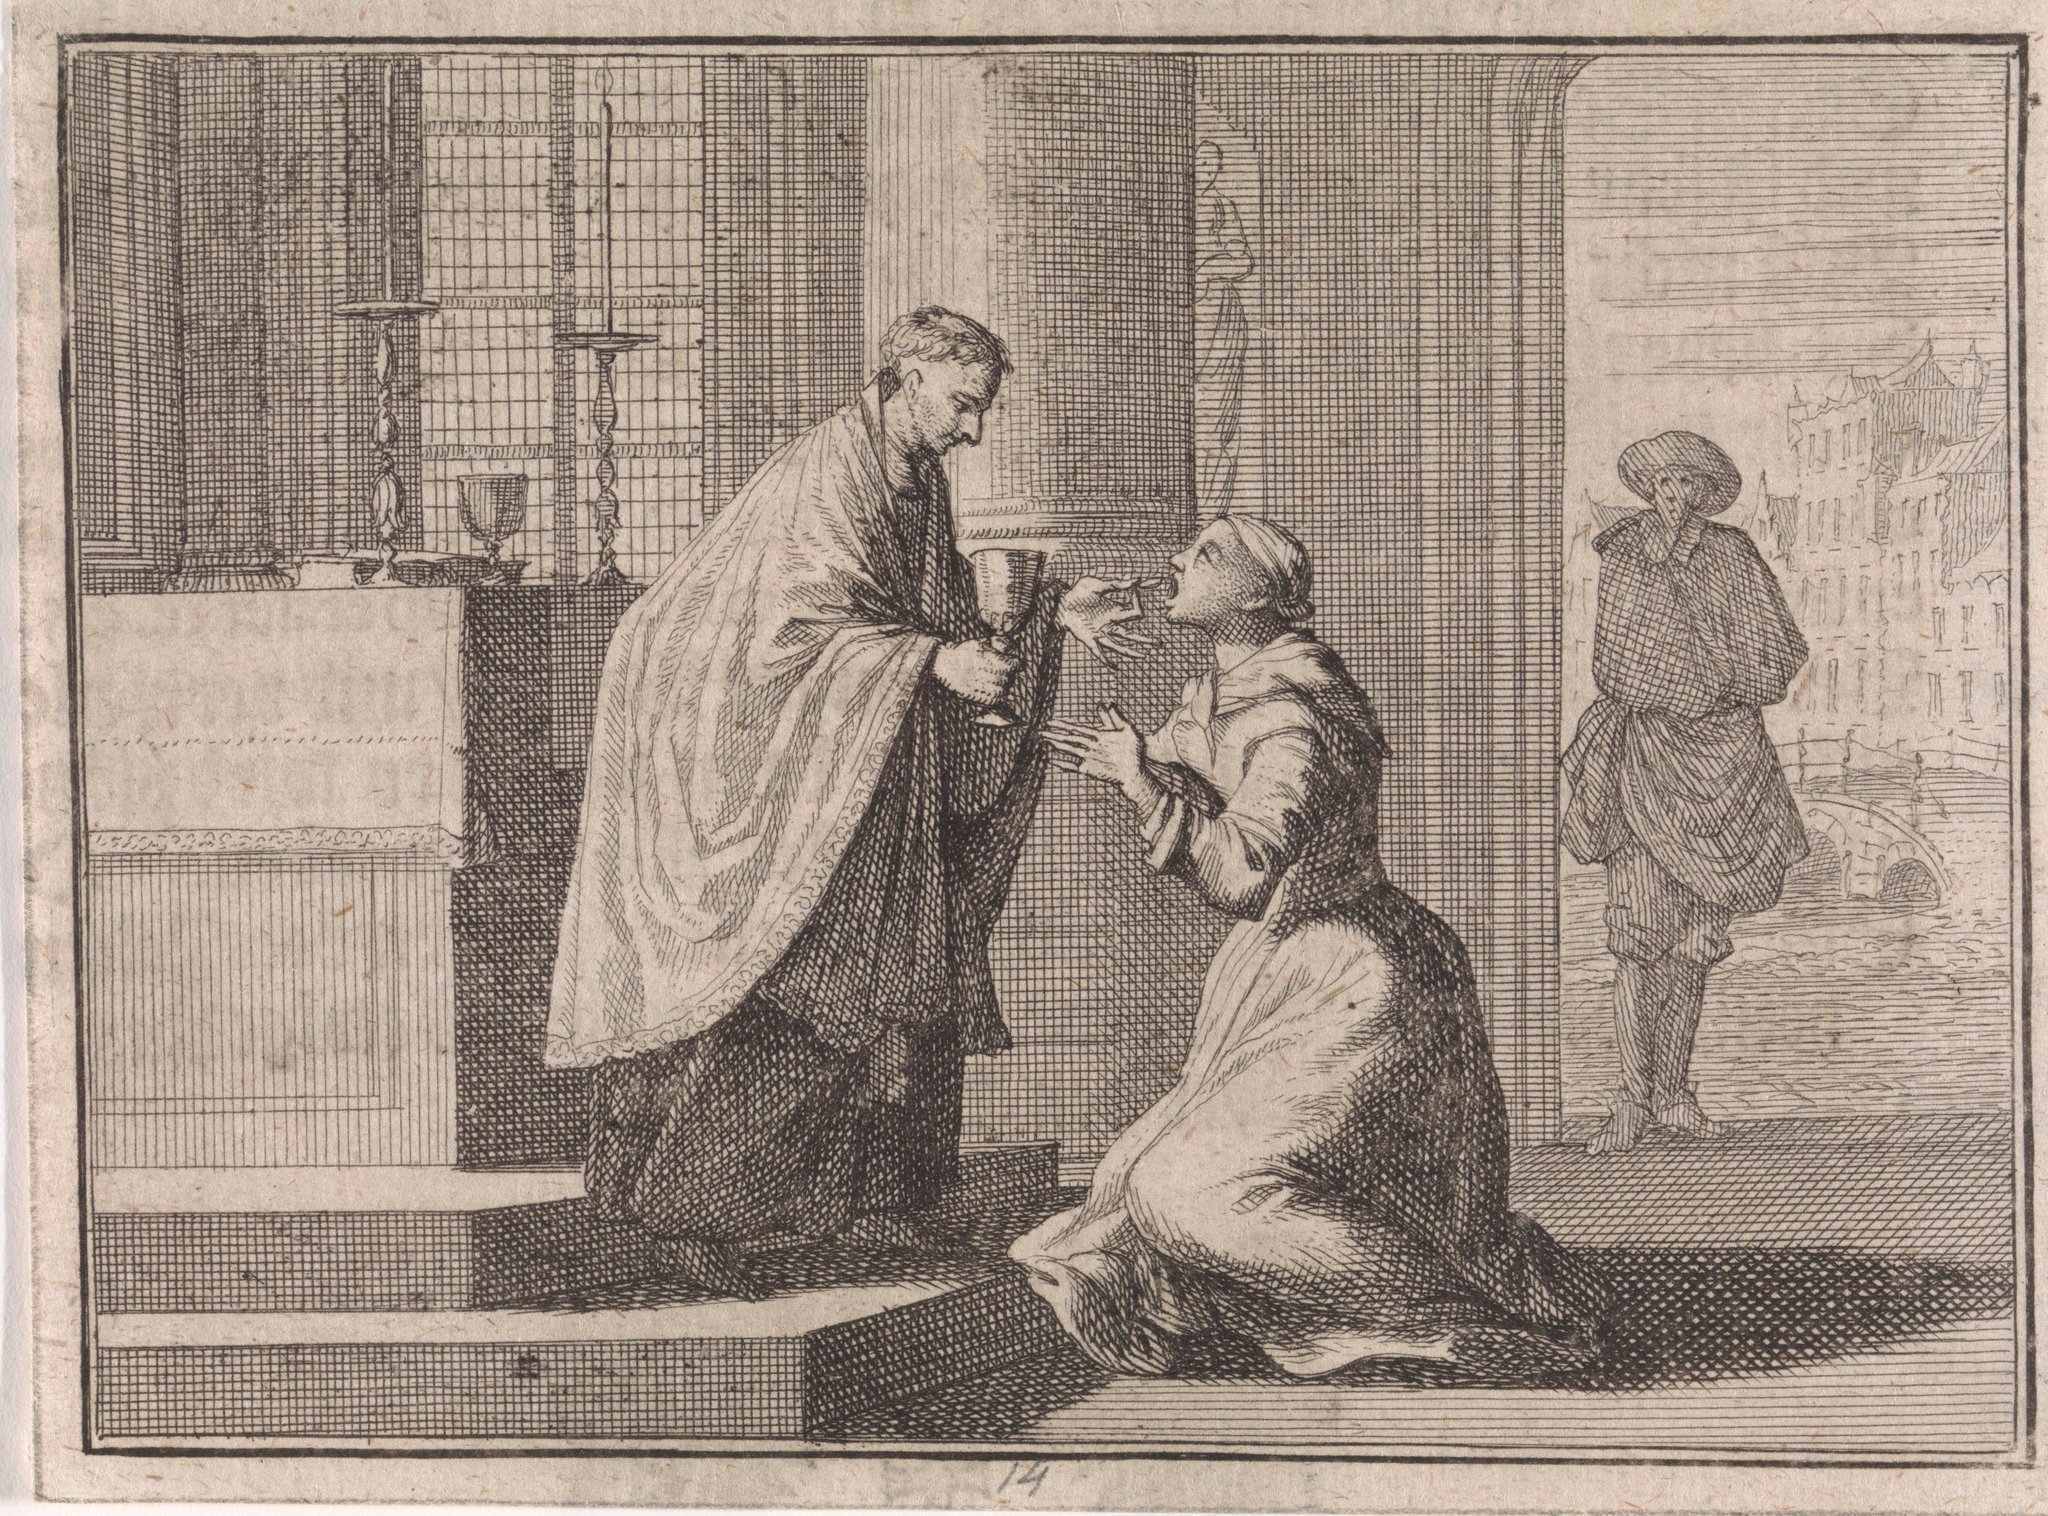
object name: book illustration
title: Wie vermessen in dem Essen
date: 1710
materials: paper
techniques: etching, letterpress printing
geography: nuremberg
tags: bread, host, priest ~ non-christian religions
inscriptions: collector's mark: Lugt 2228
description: Illustratie uit: Abraham a Sancta Clara. Heilsames Gemisch Gemasch, das ist: Allerley seltsame und verwunderliche Geschichten (...). Neurenberg: Christoph Weigel, 1710, p. 126.